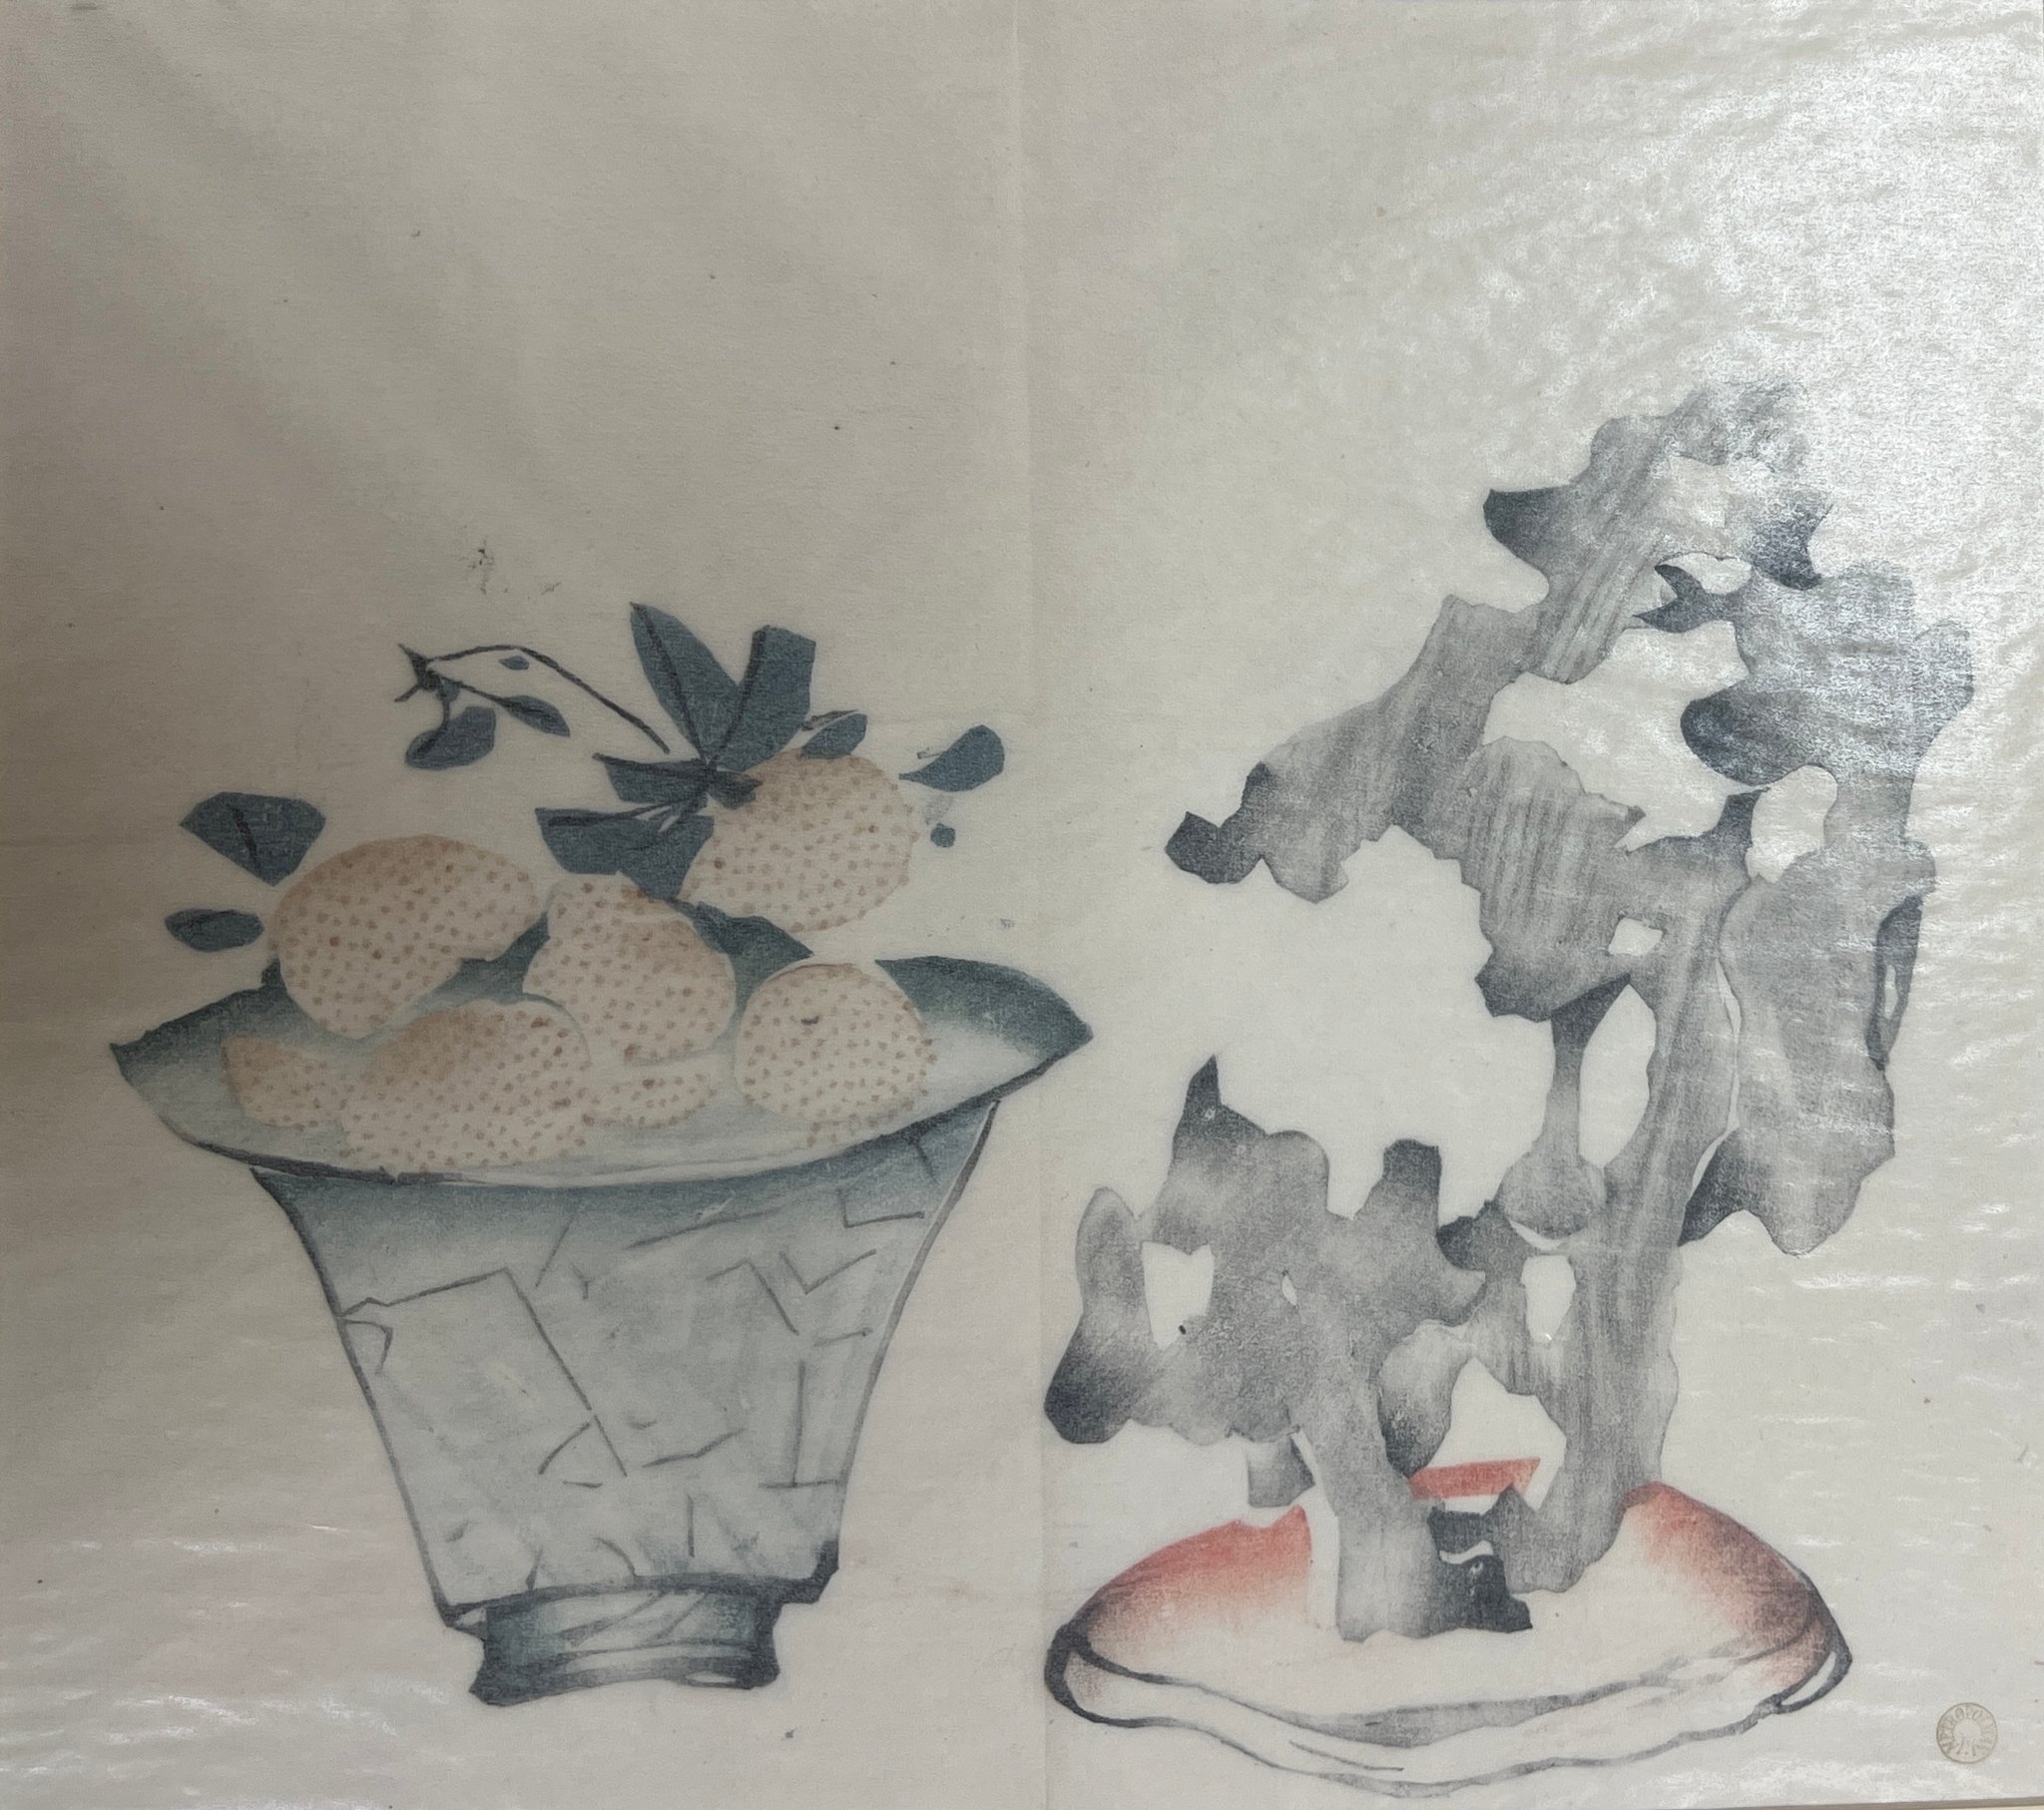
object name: print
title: Page from Ten Bamboo Studio Manual of Painting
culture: chinese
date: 1736-1795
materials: ink, paper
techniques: polychrome, woodblock print